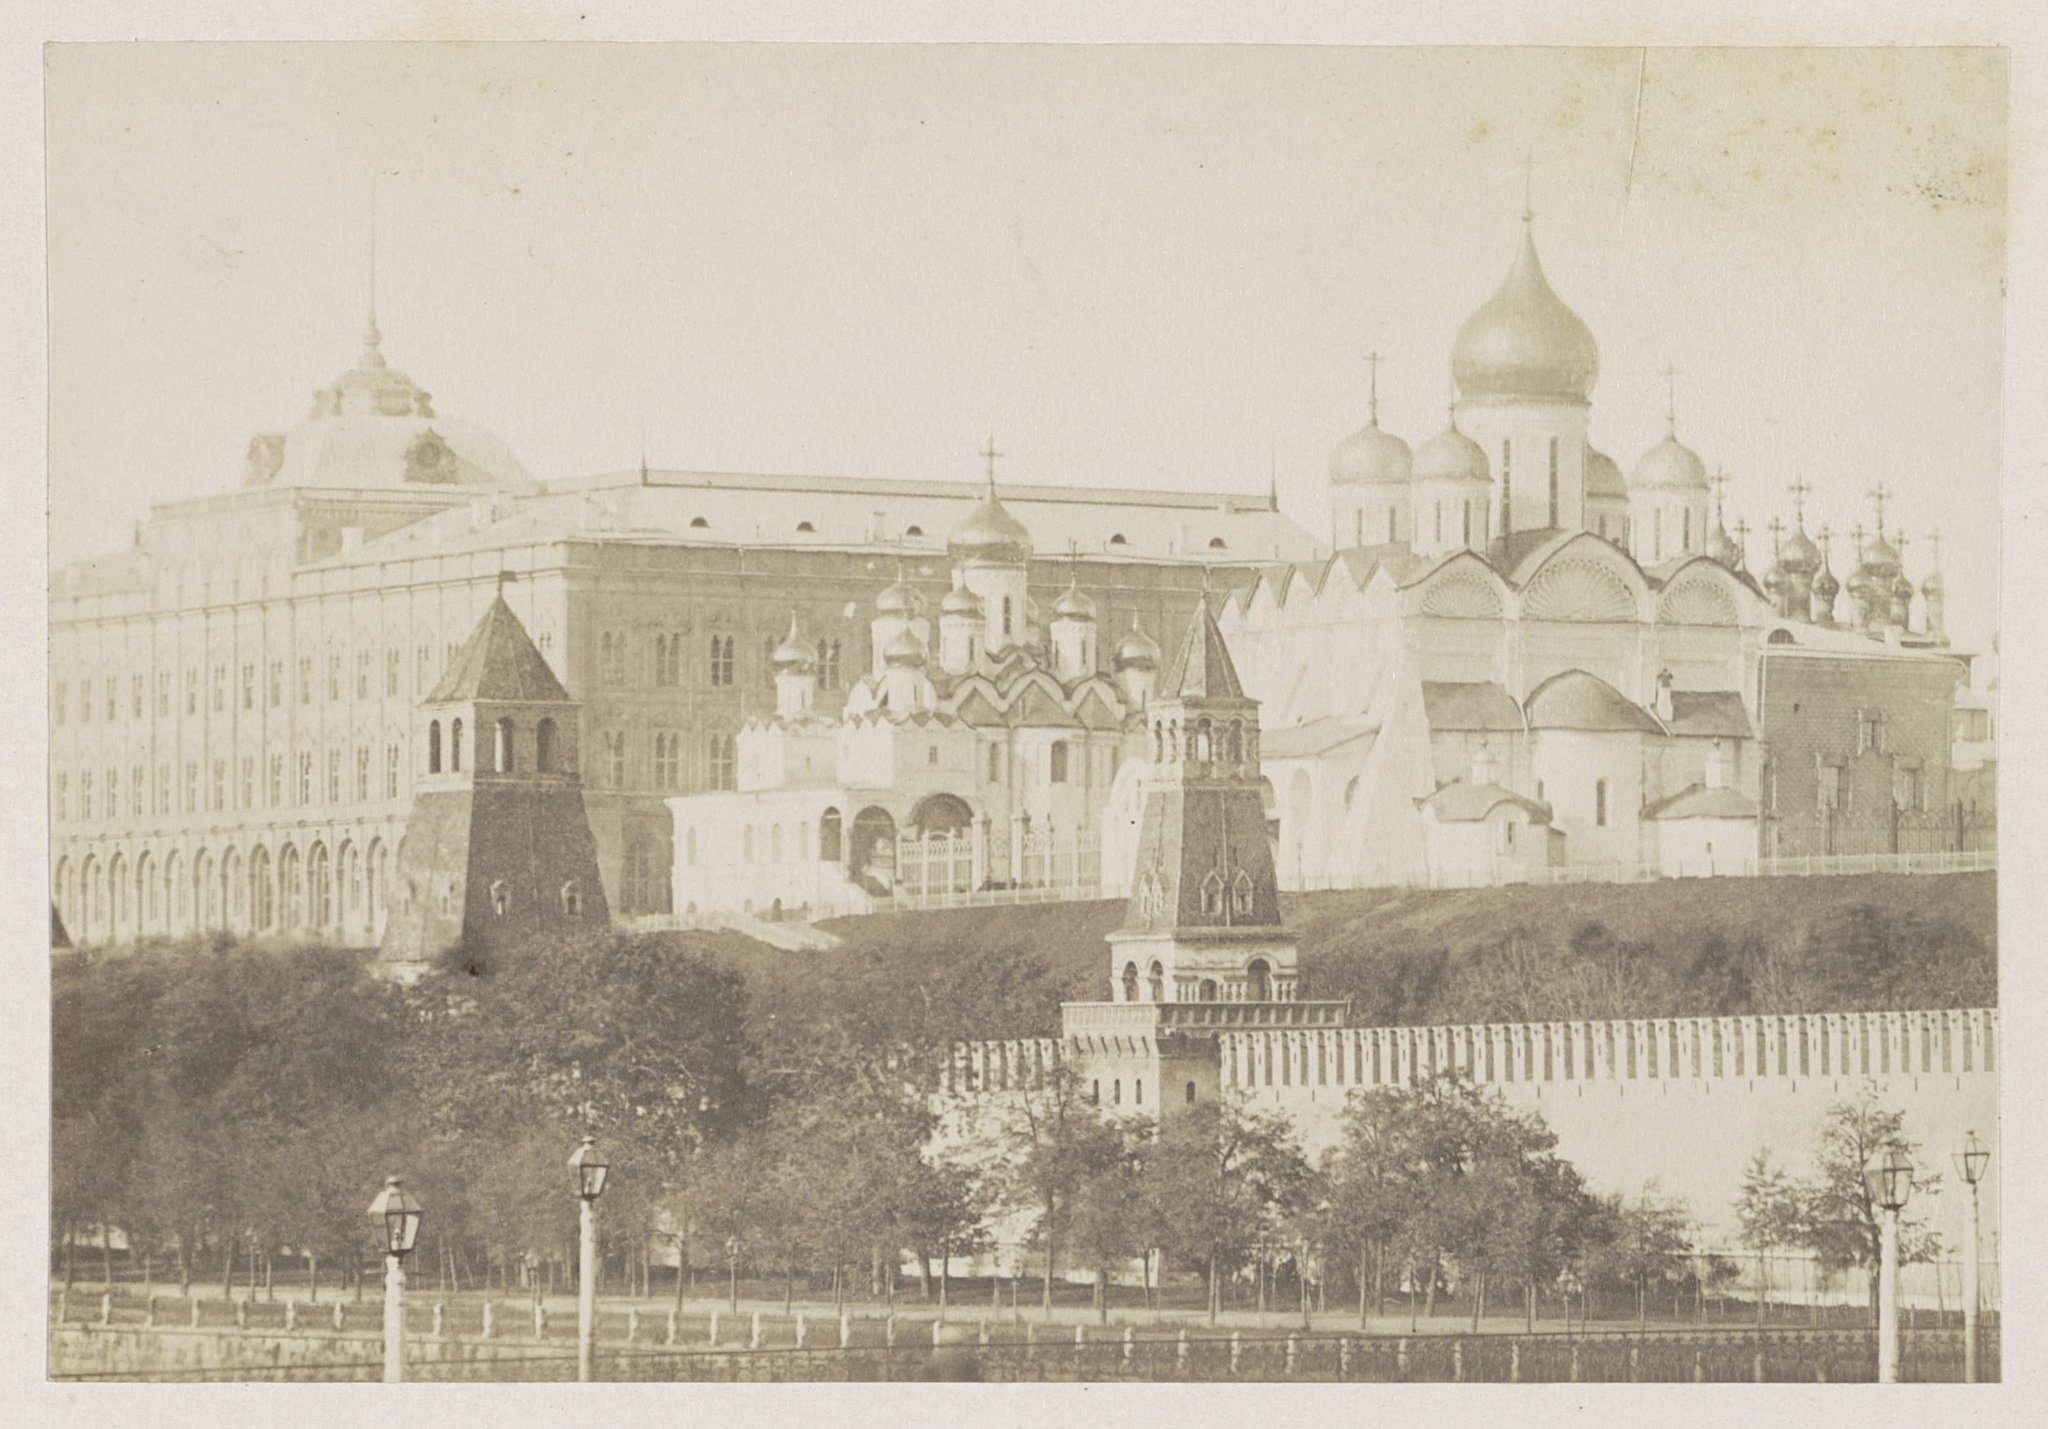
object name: photograph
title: Gezicht op het Kremlin in Moskou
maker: Anonymous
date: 1878-1890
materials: photographic support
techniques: albumen print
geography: moscow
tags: fortress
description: Onderdeel van Reisalbum Europese steden, vermoedelijk Zweeds.